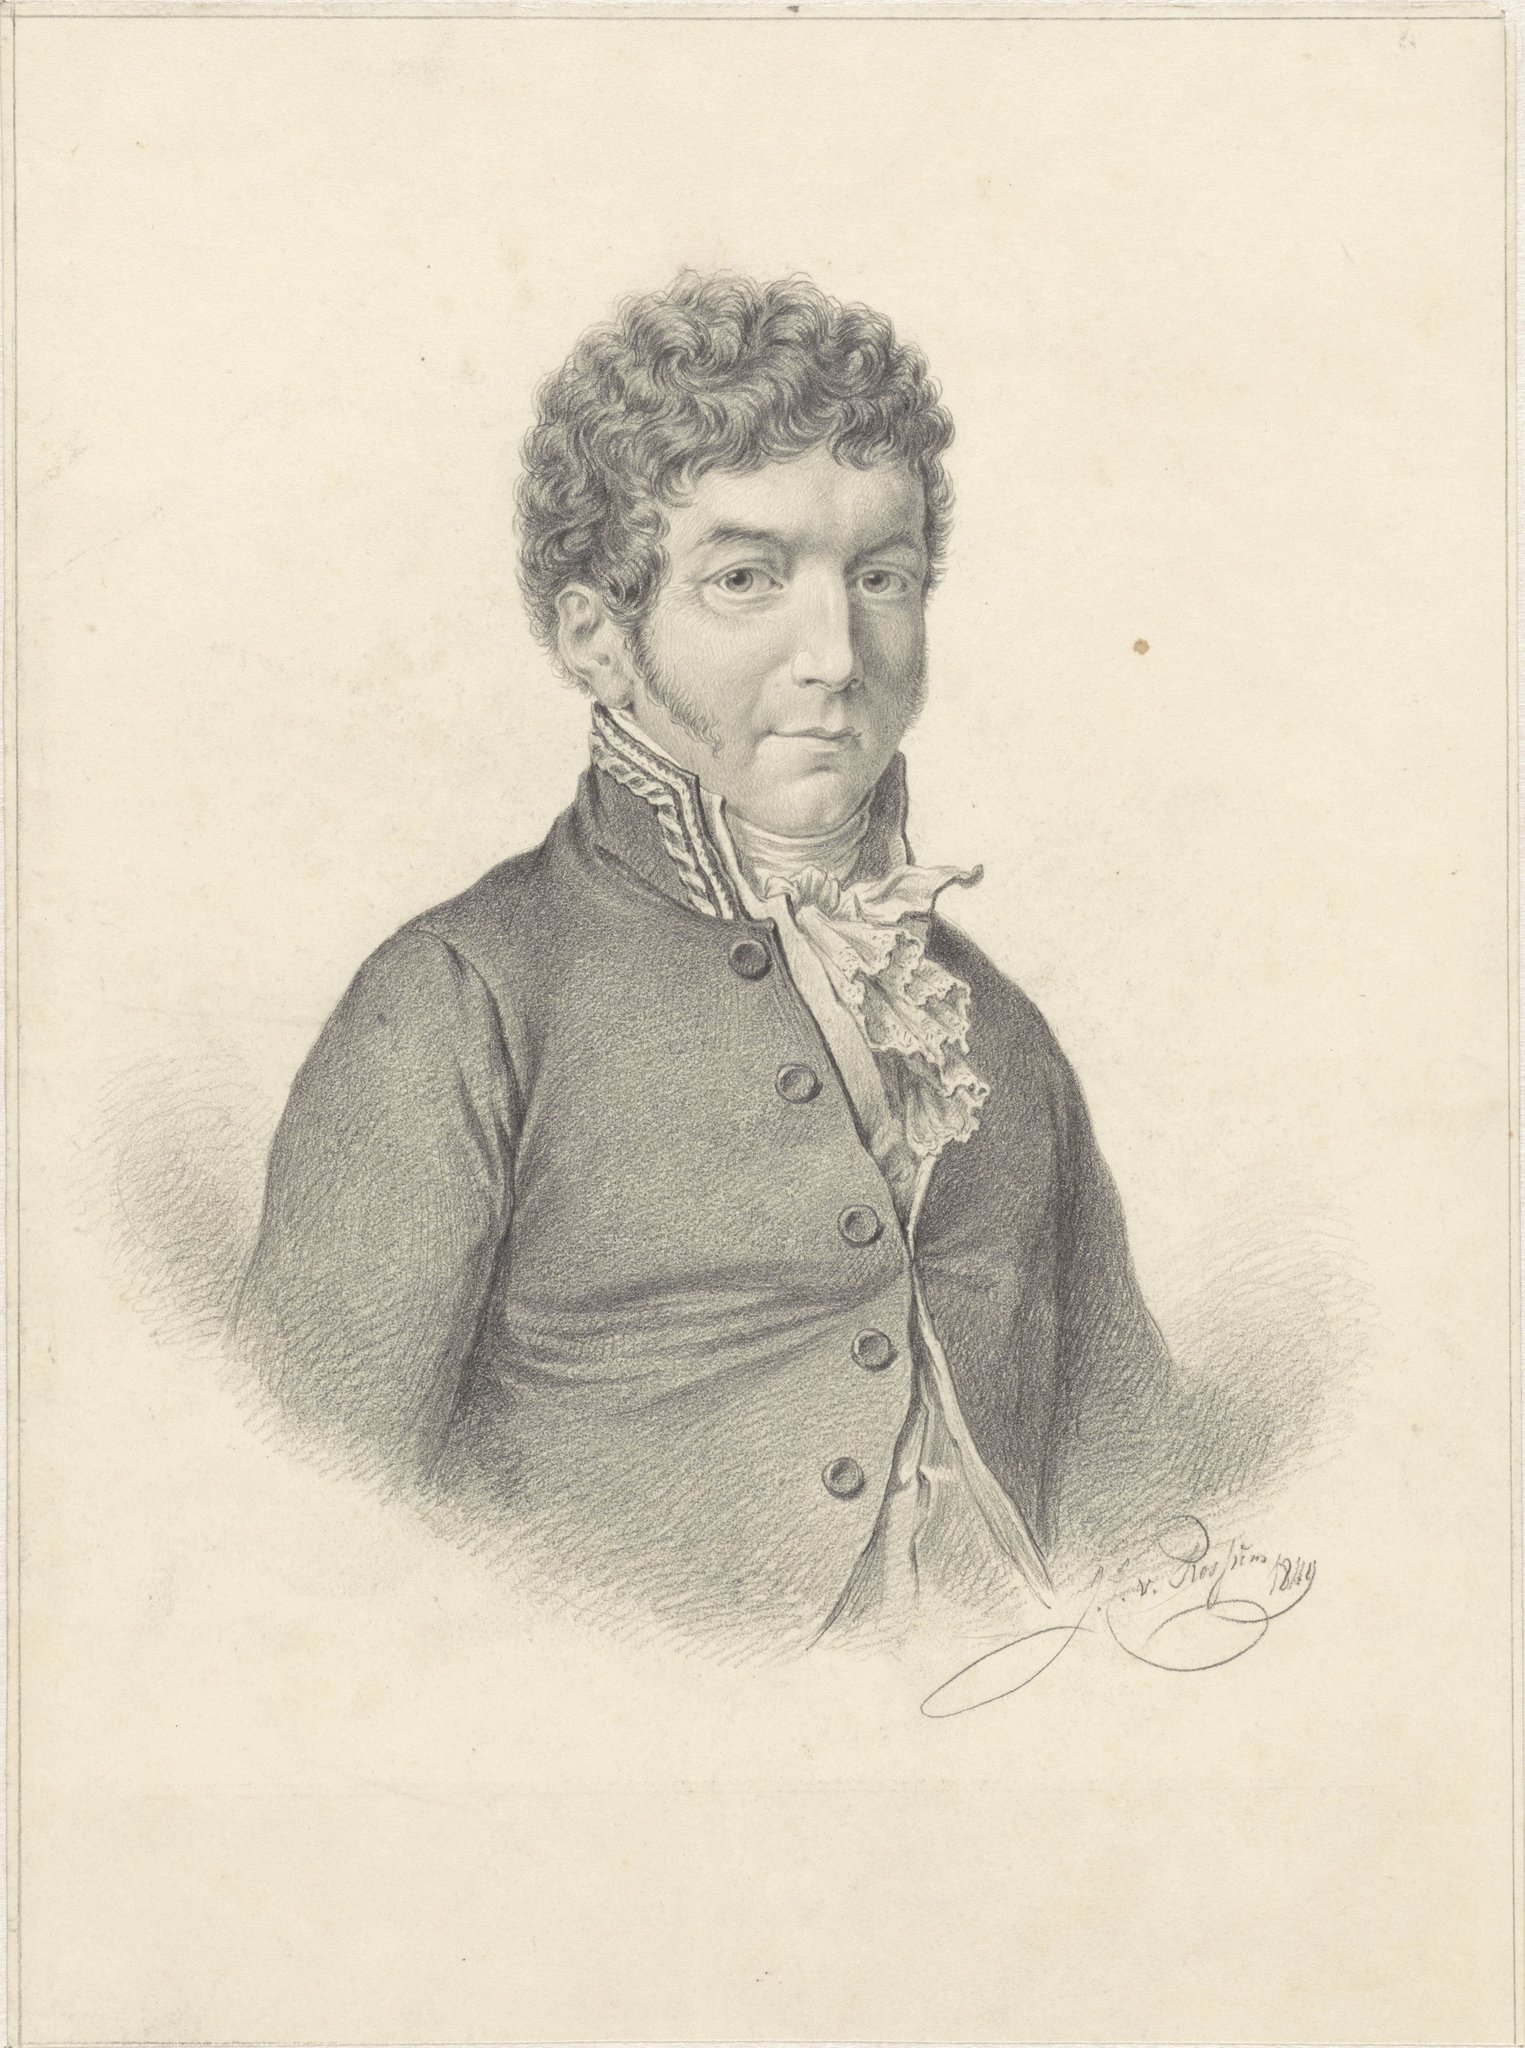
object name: drawing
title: Portret van een man, driekwart naar rechts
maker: jan cornelis van rossum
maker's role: draughtsman, painter, print maker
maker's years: 1820-1905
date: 1849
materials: paper, pencil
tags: anonymous historical person portrayed alone